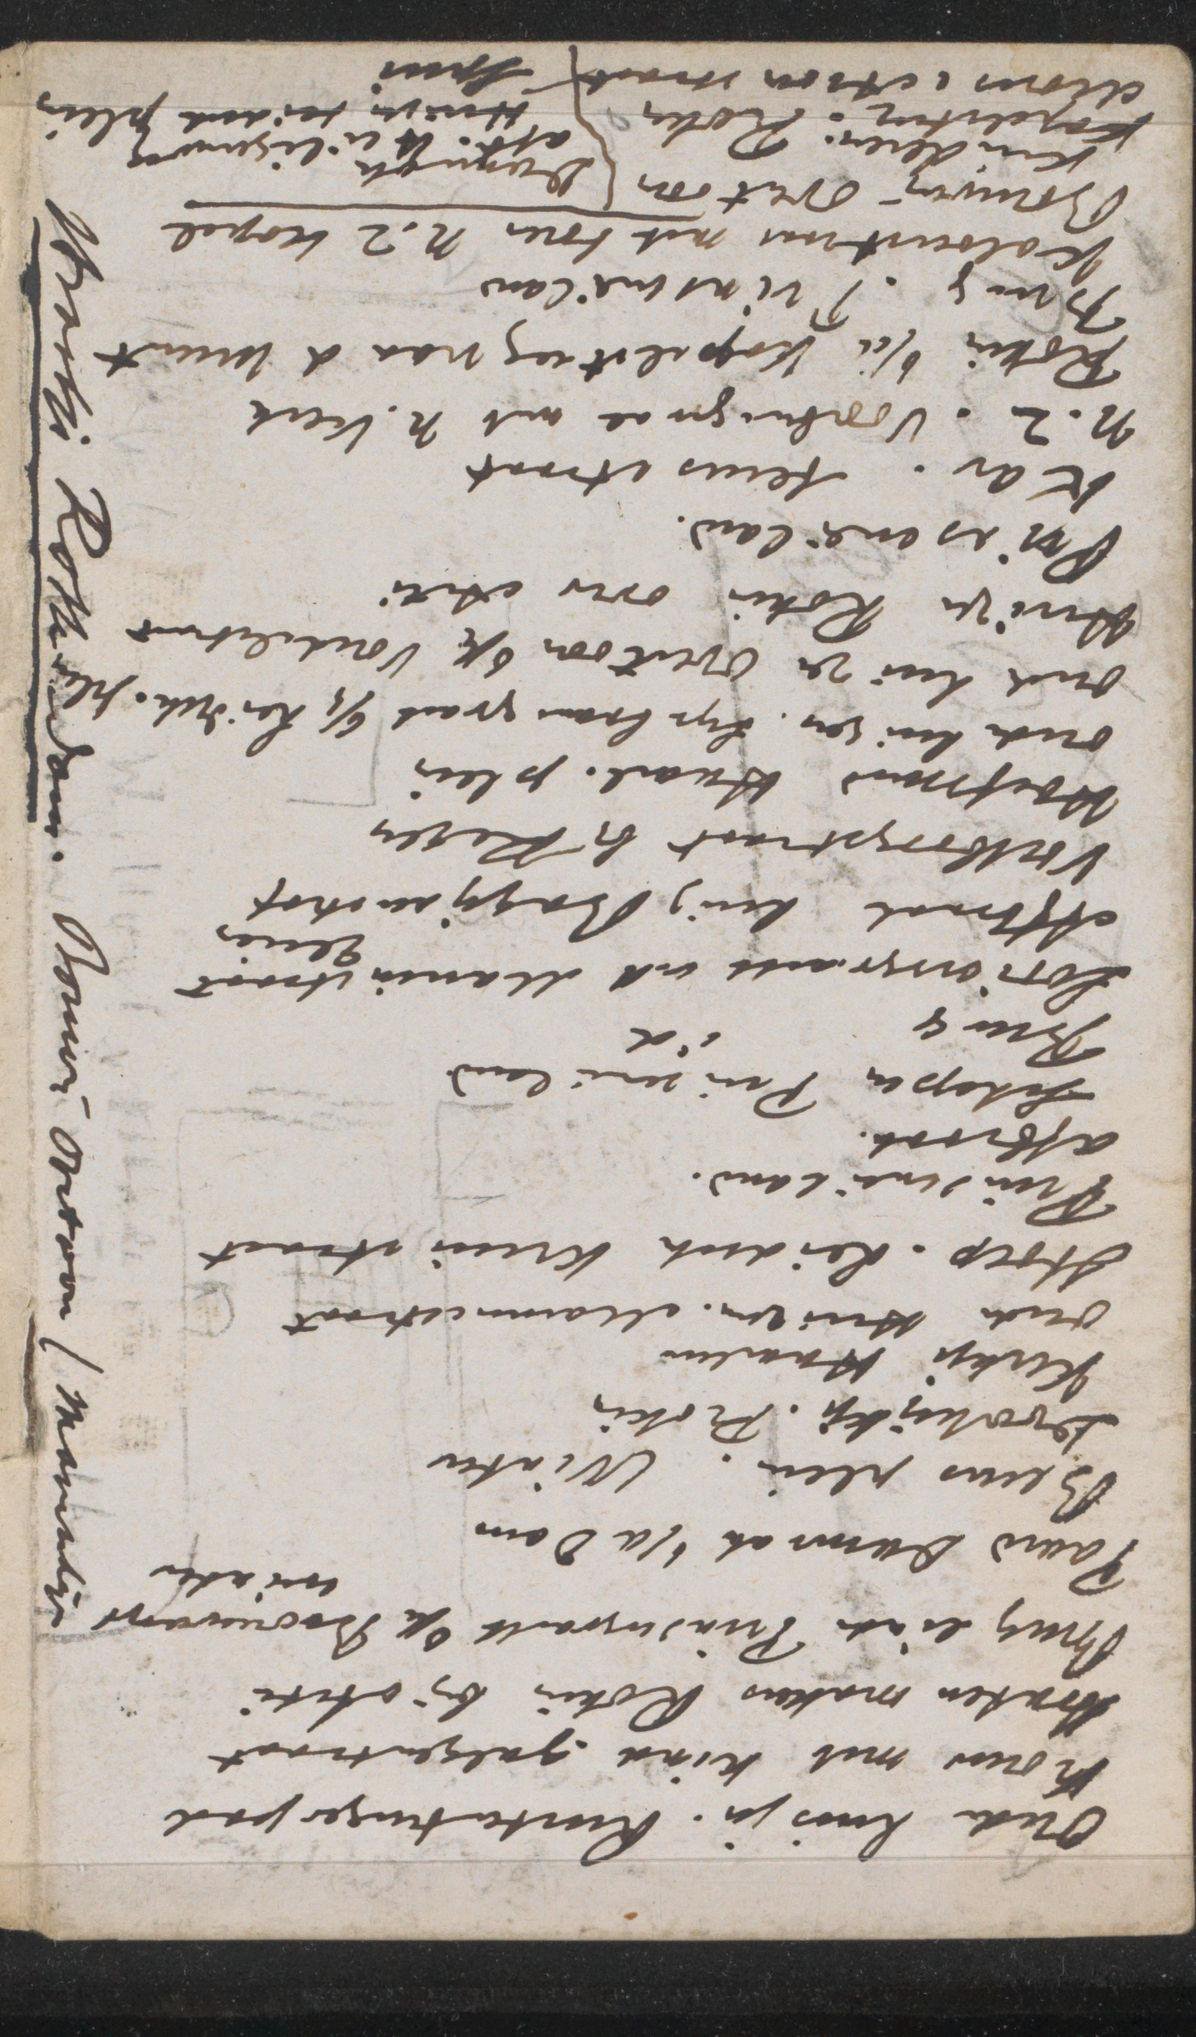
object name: endleaf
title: Annotaties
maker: george hendrik breitner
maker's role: draughtsman, painter, print maker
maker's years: 1857-1923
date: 1907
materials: ink, paper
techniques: writing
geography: amsterdam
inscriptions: annotation: ‘Oude huisjes. Rustenburgerpad/ Vrouw met kind. galgenstraat/ Straten makers Rokin bij Arti/ Brug einde Prinsengracht o/d Brouwersgr. / winter/ Paard Damrak b/d Dam/ Beurs plein. Winter/ Doorkijkje. Rokin/ Kerkje Haarlem/ Oude huizen. Marnixstraat[?]/ Stoep. Leidsche Kruis straat/ Prinseneiland./ afbraak./ Schepen Prinseneiland./ id./ Brug/ Looiersgracht v.d Marnixstraat/ gezien/ Afbraak huis Bagijnenhof [sic]/ Voetboogstraat b. Regen/ Hoefsmid Haarl. plein/ oude huizen Lijnbaansgracht b/h Leidsche plein/ oude huizen Overtoom b/d Vondelstraat/ Huizen Rokin over Arti/ Prinseneiland./ Kar. Beursstraat/ N.Z. Voorburgwal met N. Kerk/ Rokin b/d Kapelsteeg naar d Munt/ Brug. Prinseneiland/ Kalverstraat met toren N.Z Kapel/ Bouwrij Overtoom/ Kinderen./ Kapelsteeg. Rokin/ Mozes en Aronstraat [sic]/ Damrak/ afb. Heiligenweg/ Huizen Leidsche plein/ Spui/ straatje Rotterdam. Bouwrij Overtoom (maneschijn)’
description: Annotaties. Pagina 94, achterste schutblad, uit een schetsboek met 46 bladen vervaardigd in Amsterdam, Rotterdam en Haarlem.